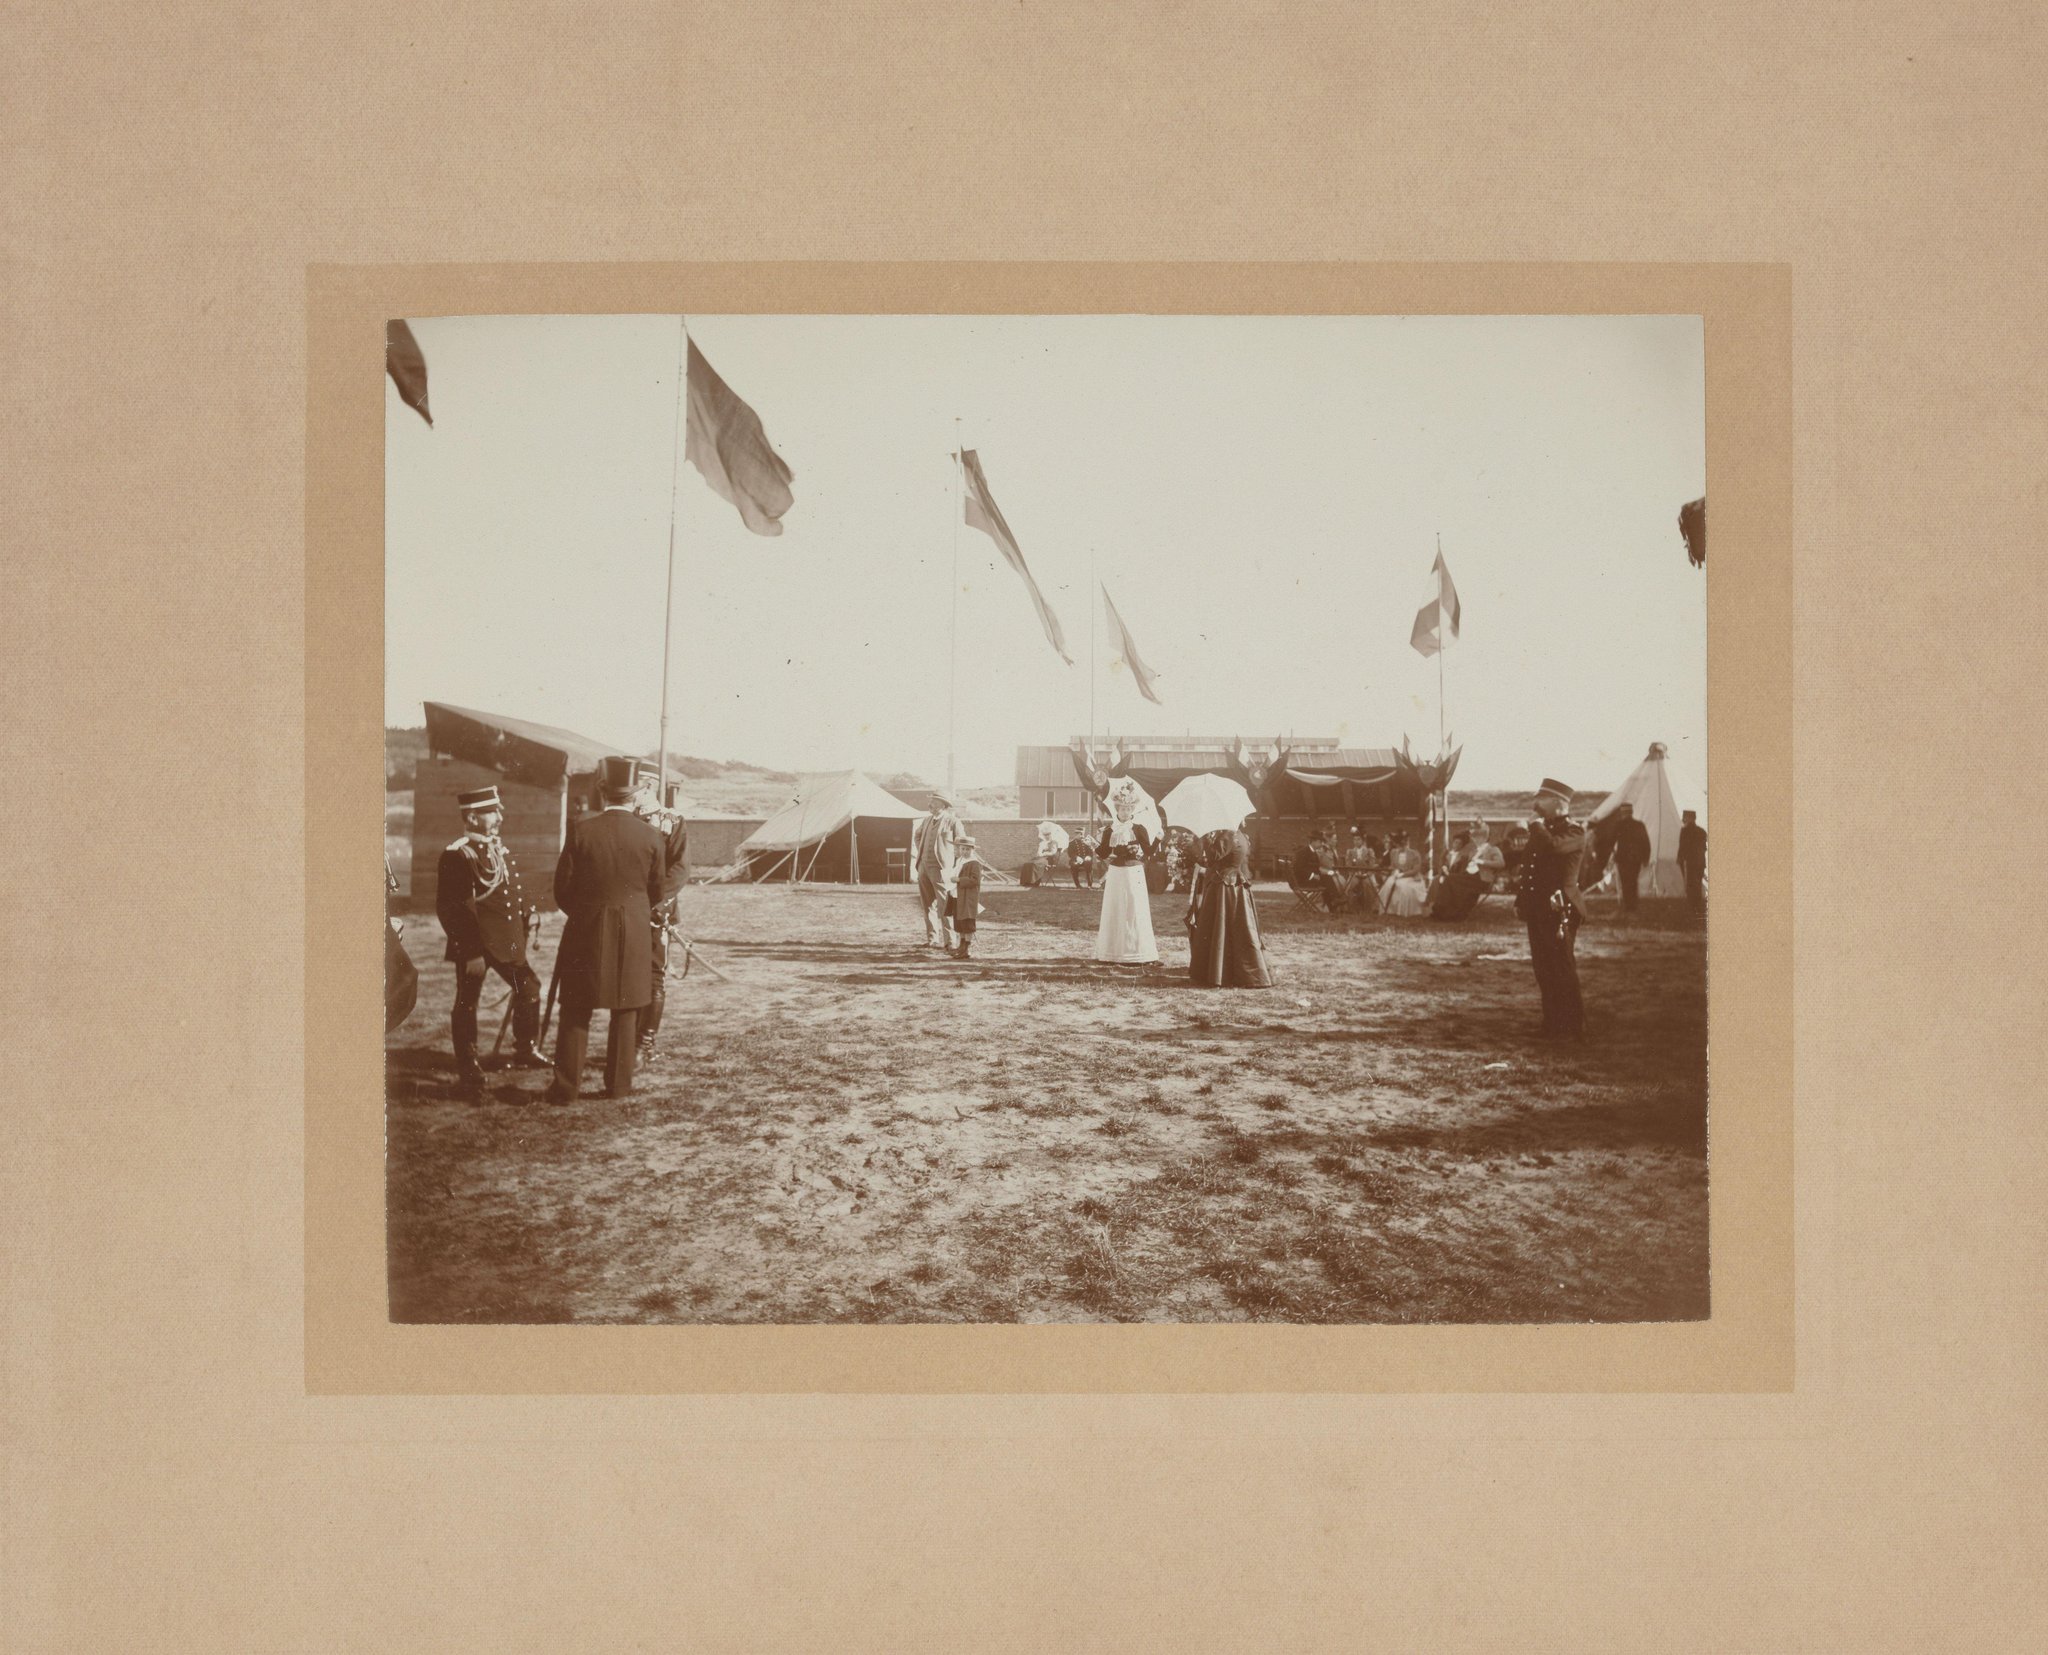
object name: photograph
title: Koninklijk bezoek bij militaire post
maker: jan willem arnold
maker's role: fotograaf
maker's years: 1842-1909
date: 1901-1915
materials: cardboard, photographic support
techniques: albumen print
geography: the hague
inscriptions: stamp: ‘Photographie Viennoise J.W. Arnold Tellensstraat 98 's-Gravenhage’, date: ‘A: 1899’